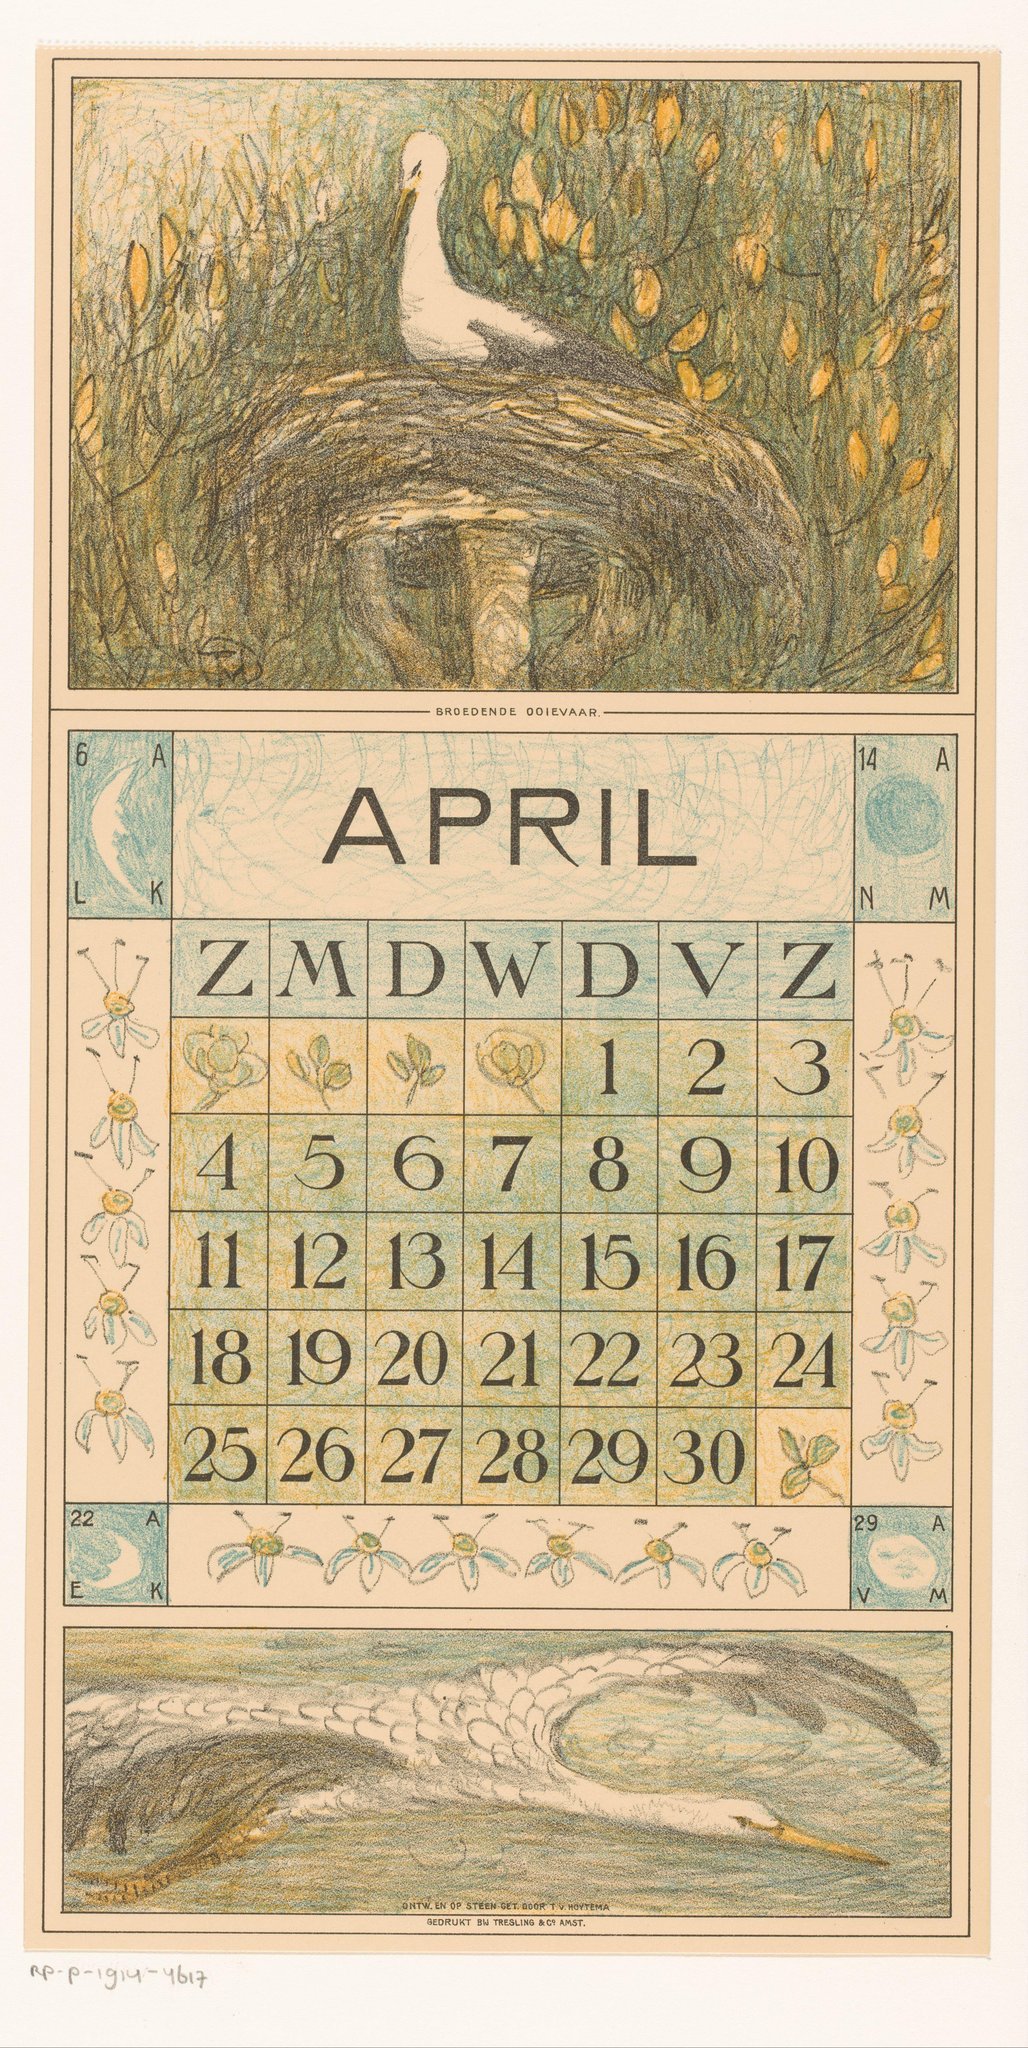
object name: print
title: Kalenderblad april met ooievaar op het nest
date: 1914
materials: paper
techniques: lithograph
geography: the hague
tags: shore-birds and wading-birds: stork, lunar year, april ~ other concepts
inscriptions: collector's mark: Lugt 2233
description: Onderin een vliegende ooievaar. In de hoeken de standen van de maan op vier dagen. Bovenaan het blad een scheurlijn.